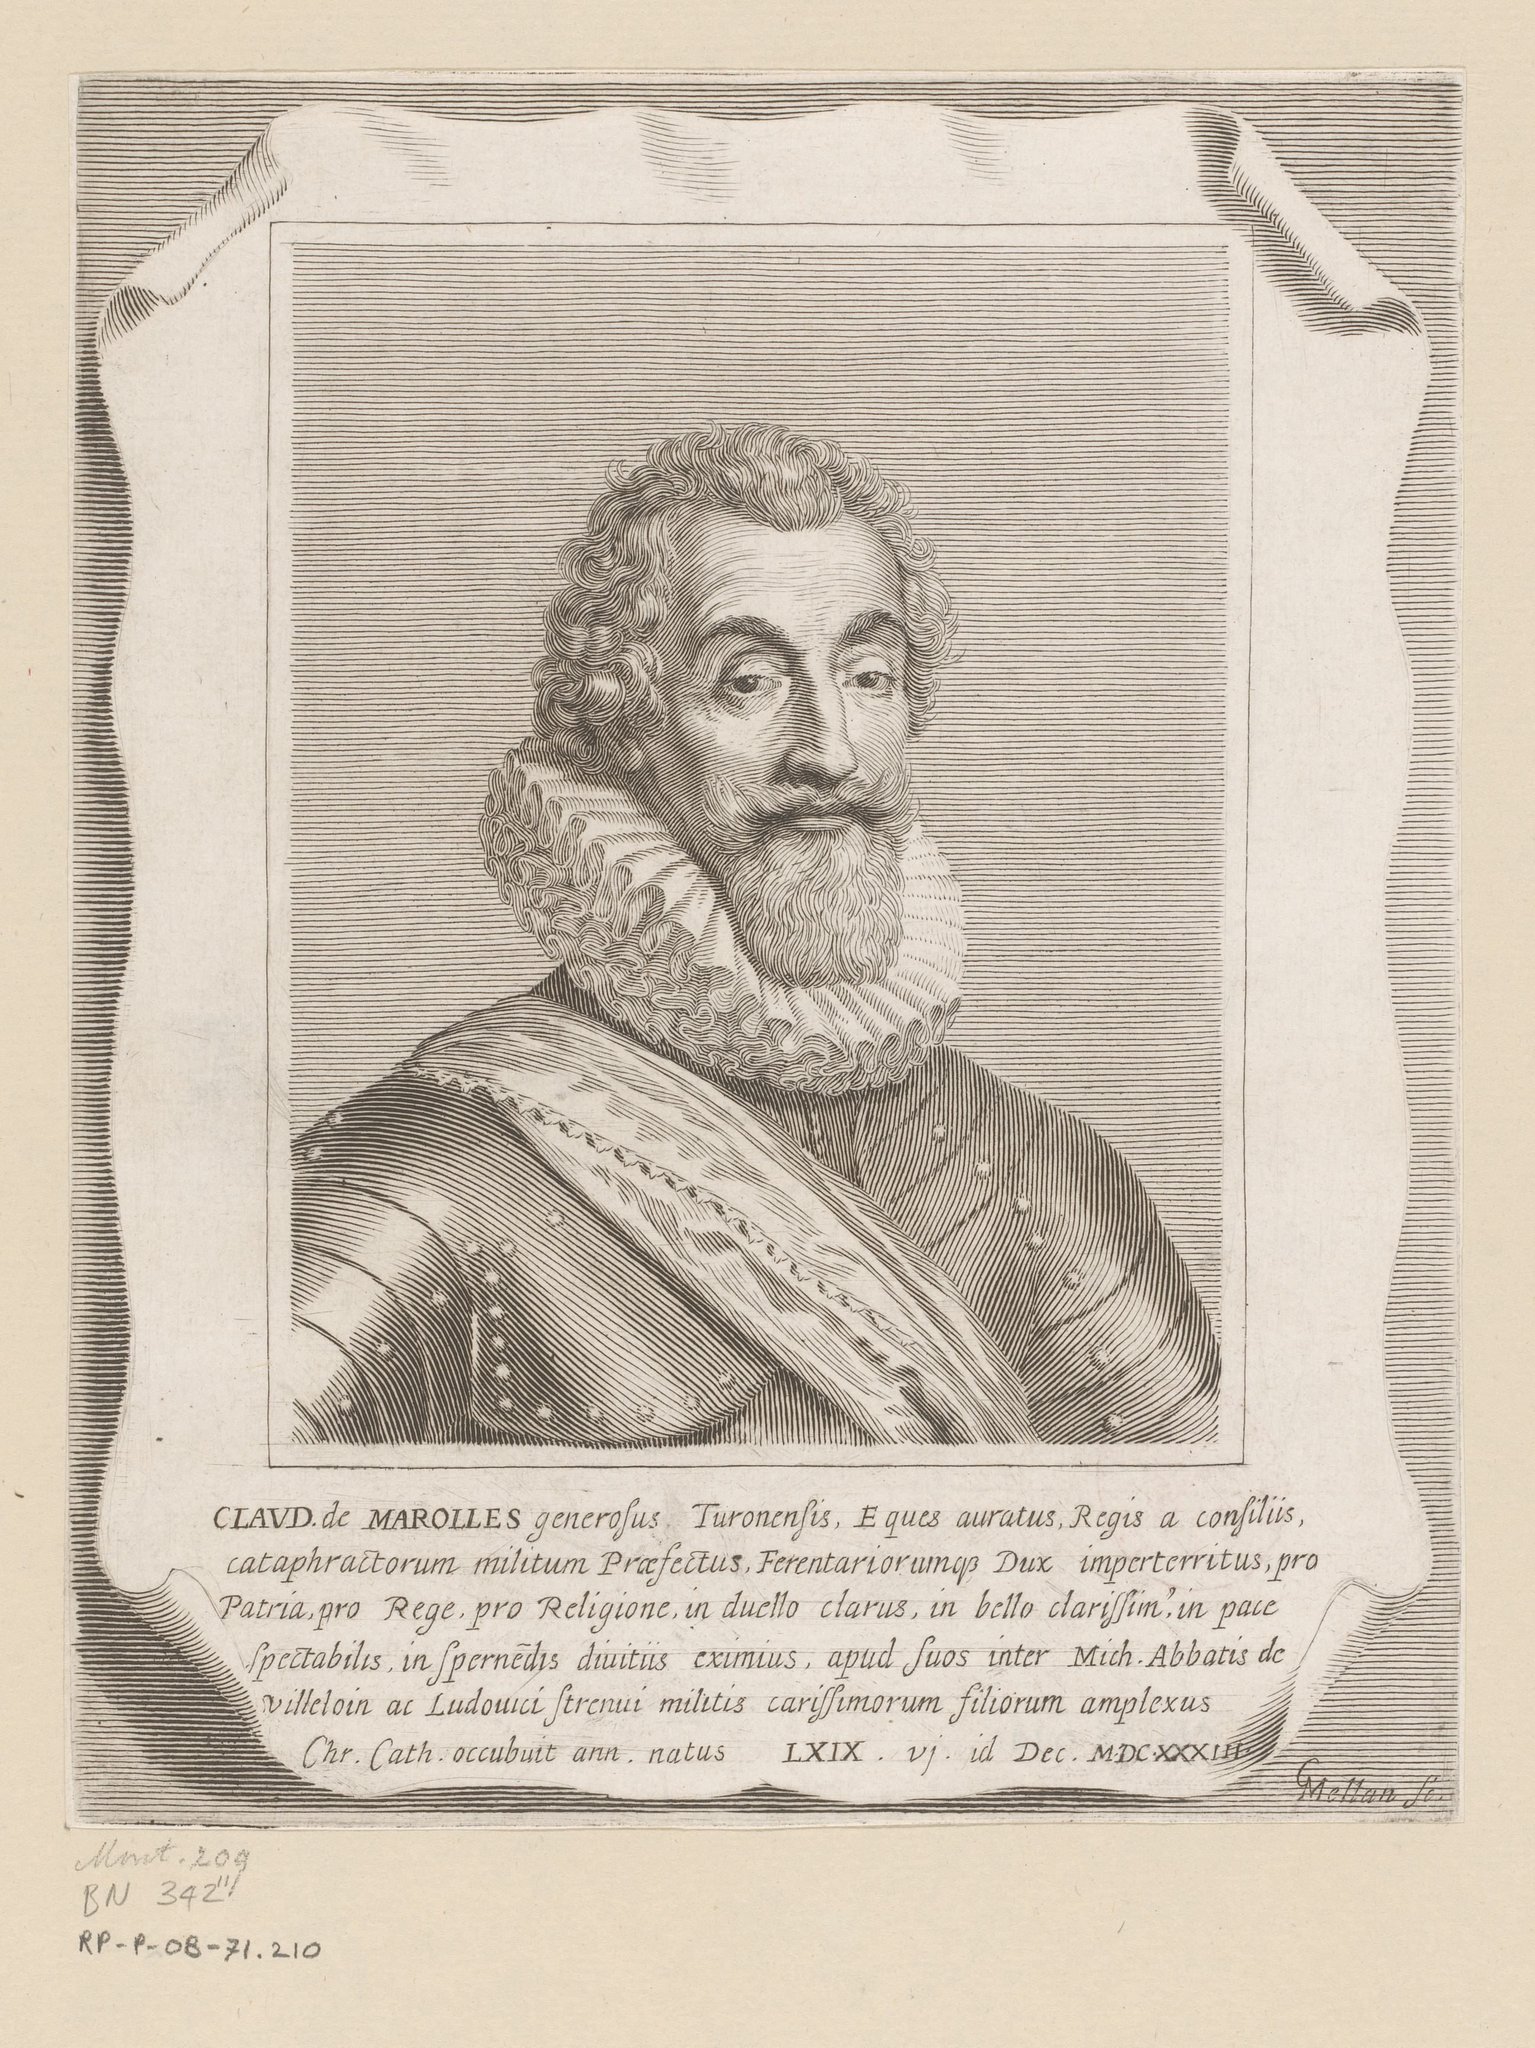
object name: book illustration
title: Portret van Claude de Marolles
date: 1656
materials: paper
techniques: engraving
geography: paris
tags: historical persons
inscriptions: collector's mark: Lugt 240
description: Prent gebruikt voor: Marolles, Michel de. Les Mémoires de Michel de Marolles, abbé de Villeloin. Parijs: Antoine de Sommaville, 1656.